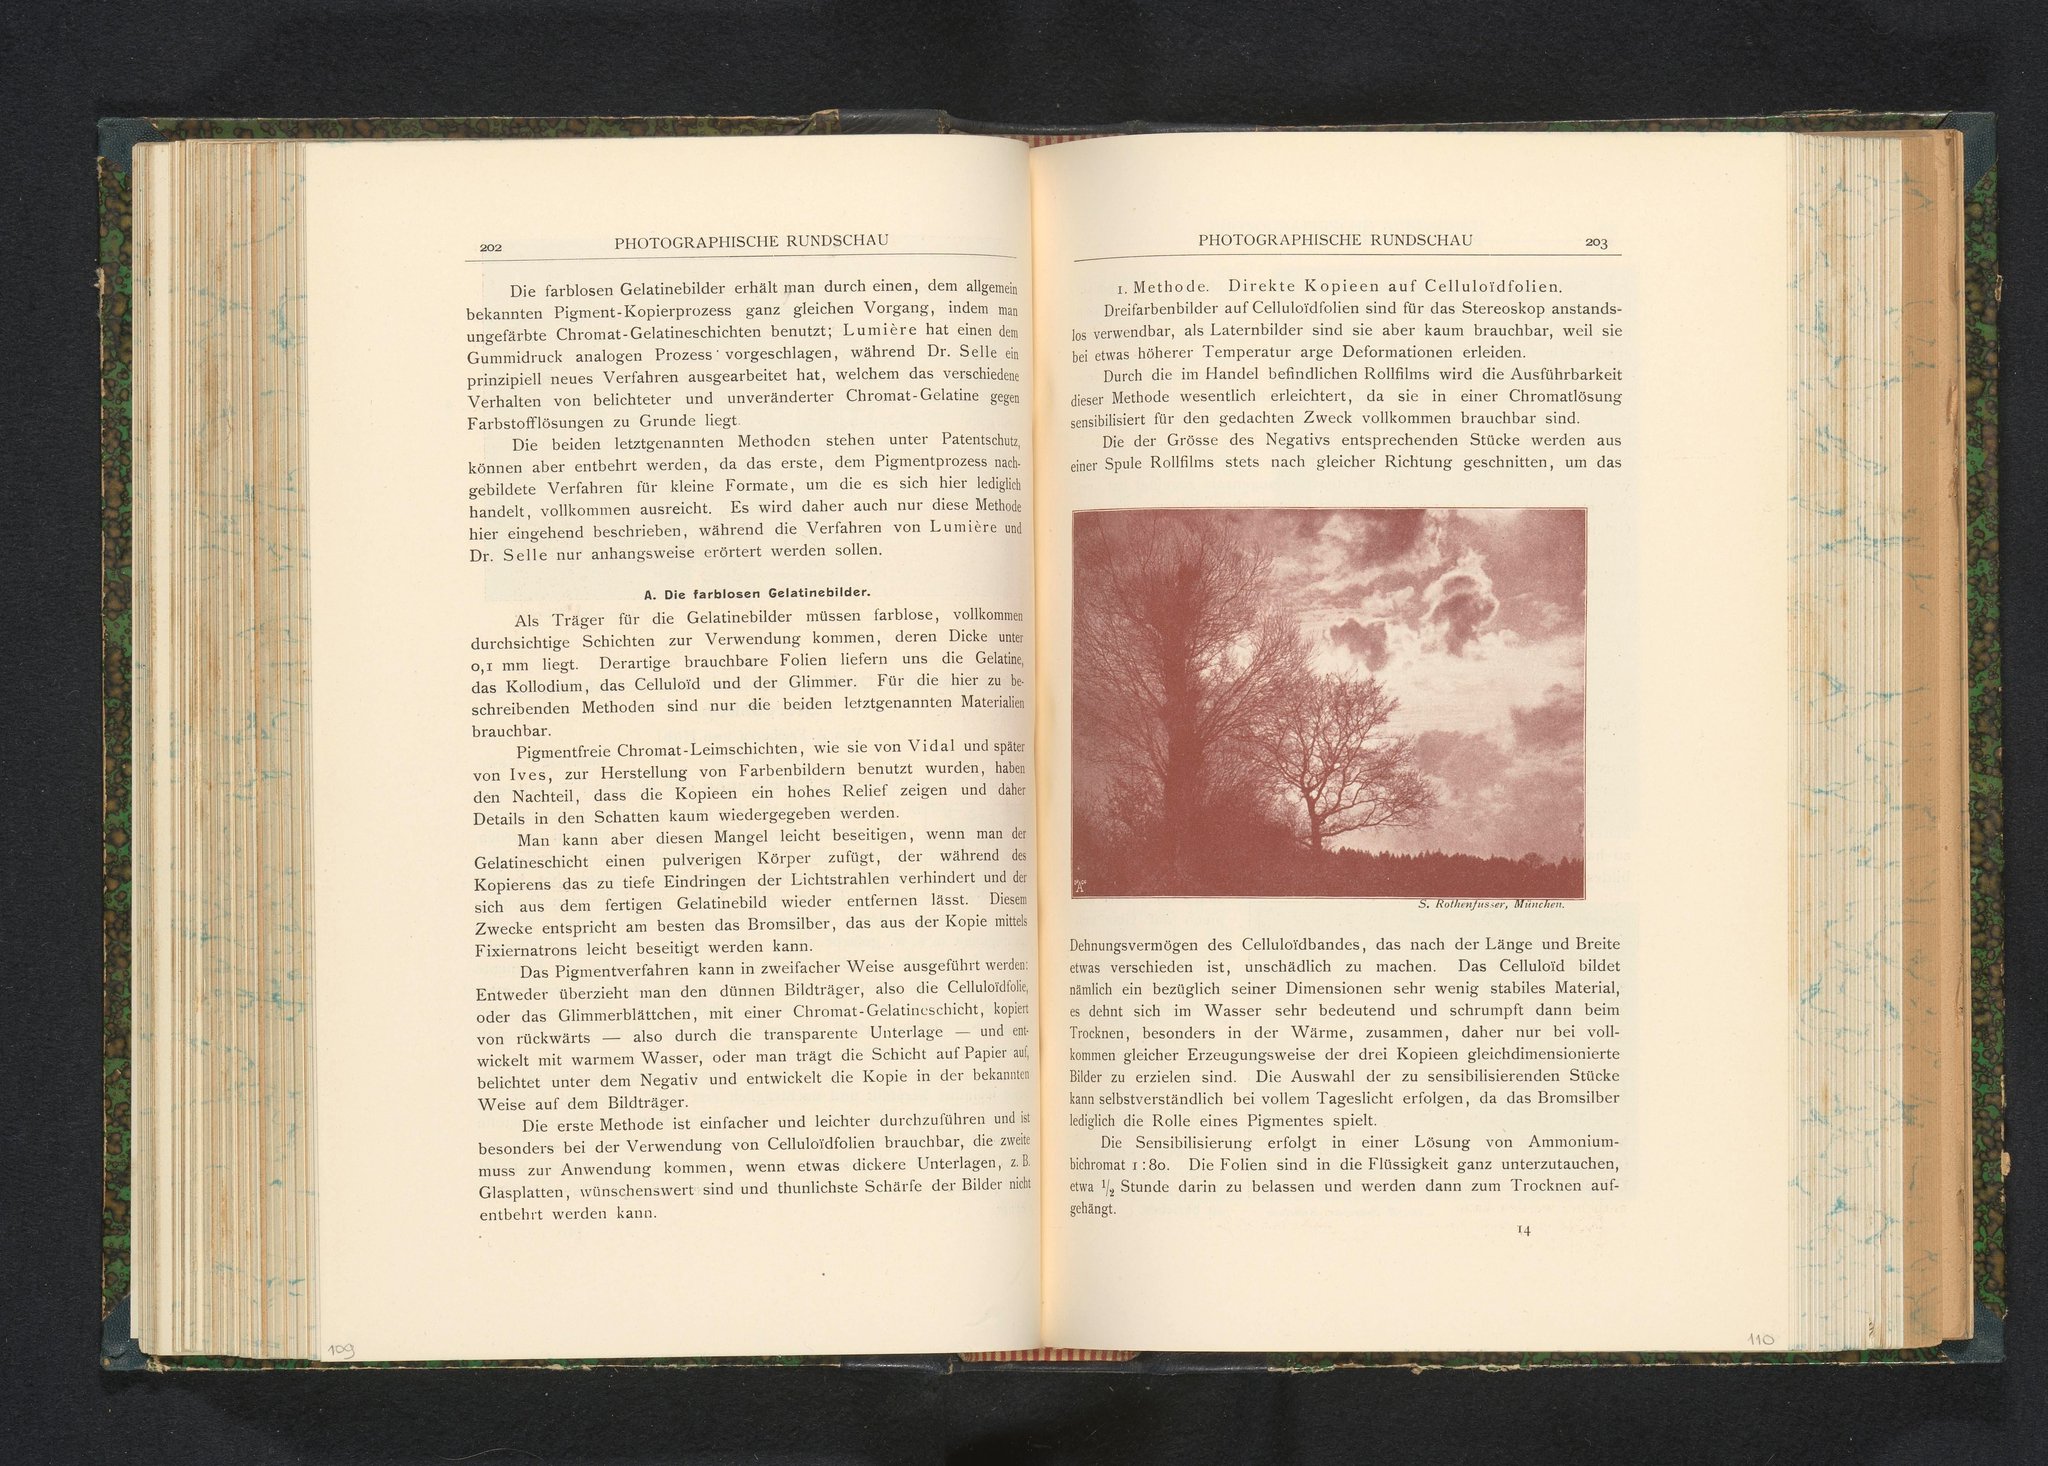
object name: page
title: Gezicht op een landschap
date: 1894-1899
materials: paper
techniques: autotype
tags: landscapes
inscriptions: monogram: ‘Dr A Co’